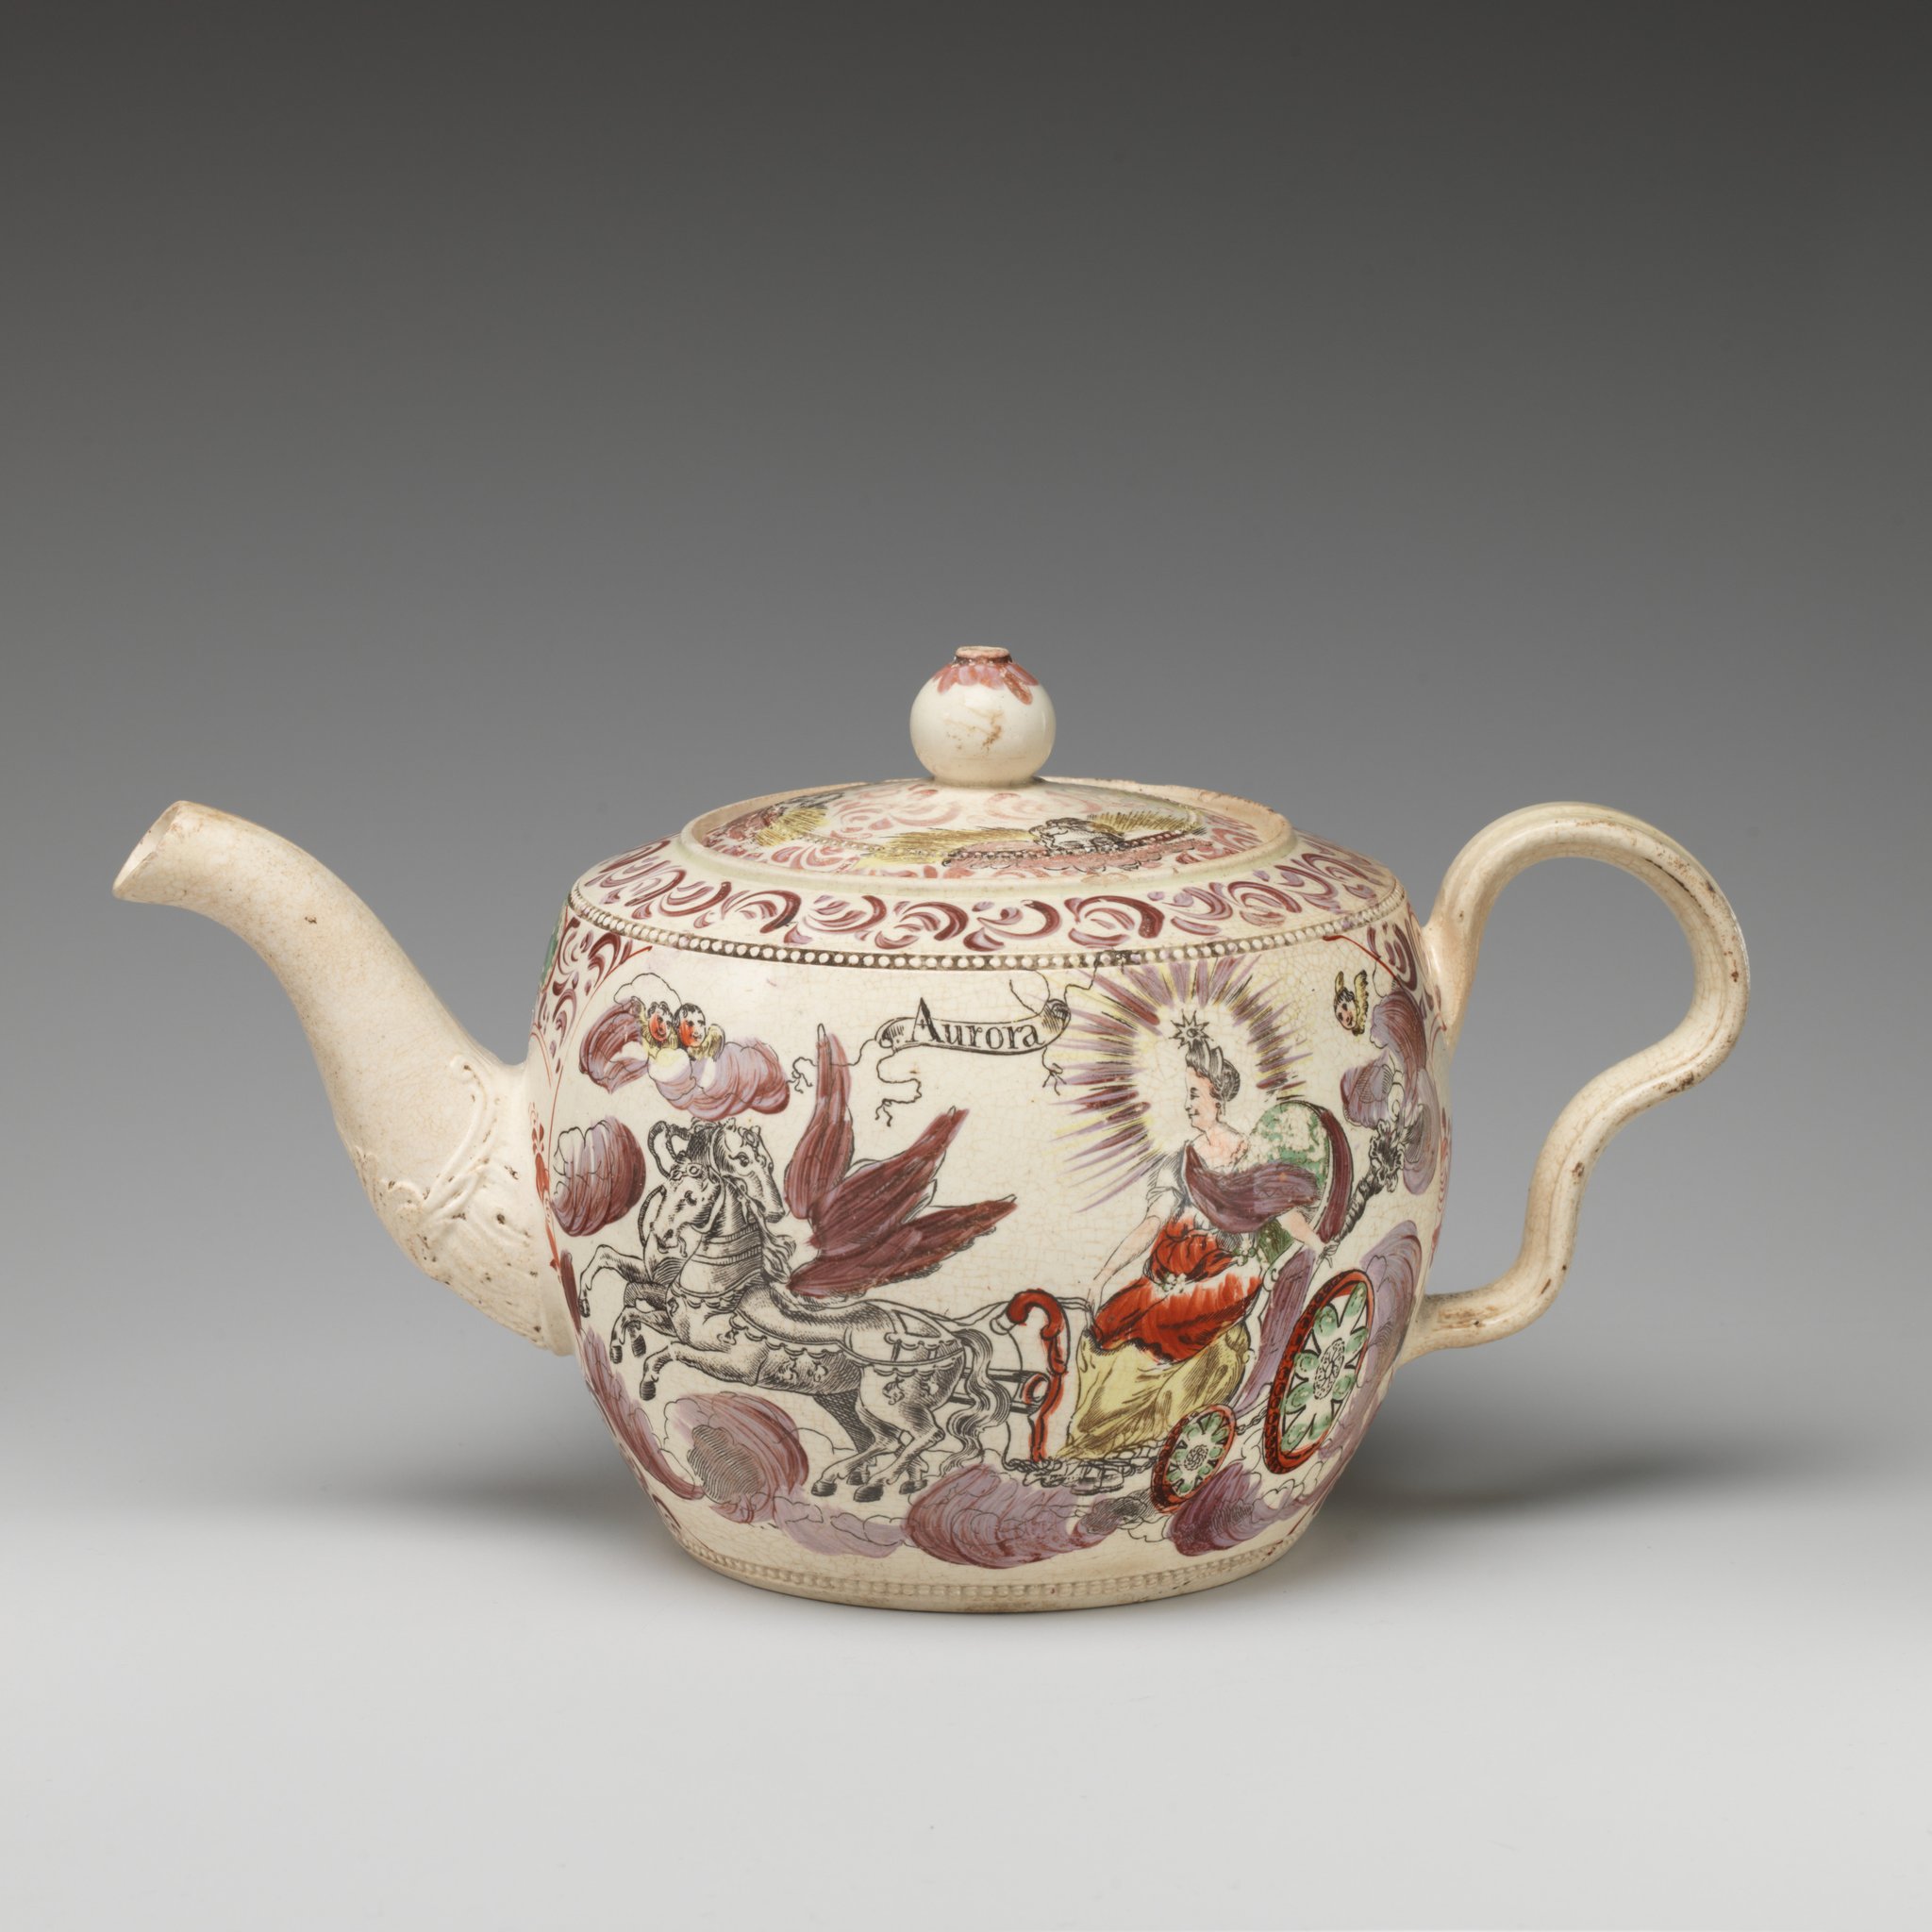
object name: teapot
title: Teapot with Aurora riding in her chariot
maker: william greatbach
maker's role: designer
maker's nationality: british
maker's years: 1735-1813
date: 1770-1782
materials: creamware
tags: women,pegasus,sun,maps